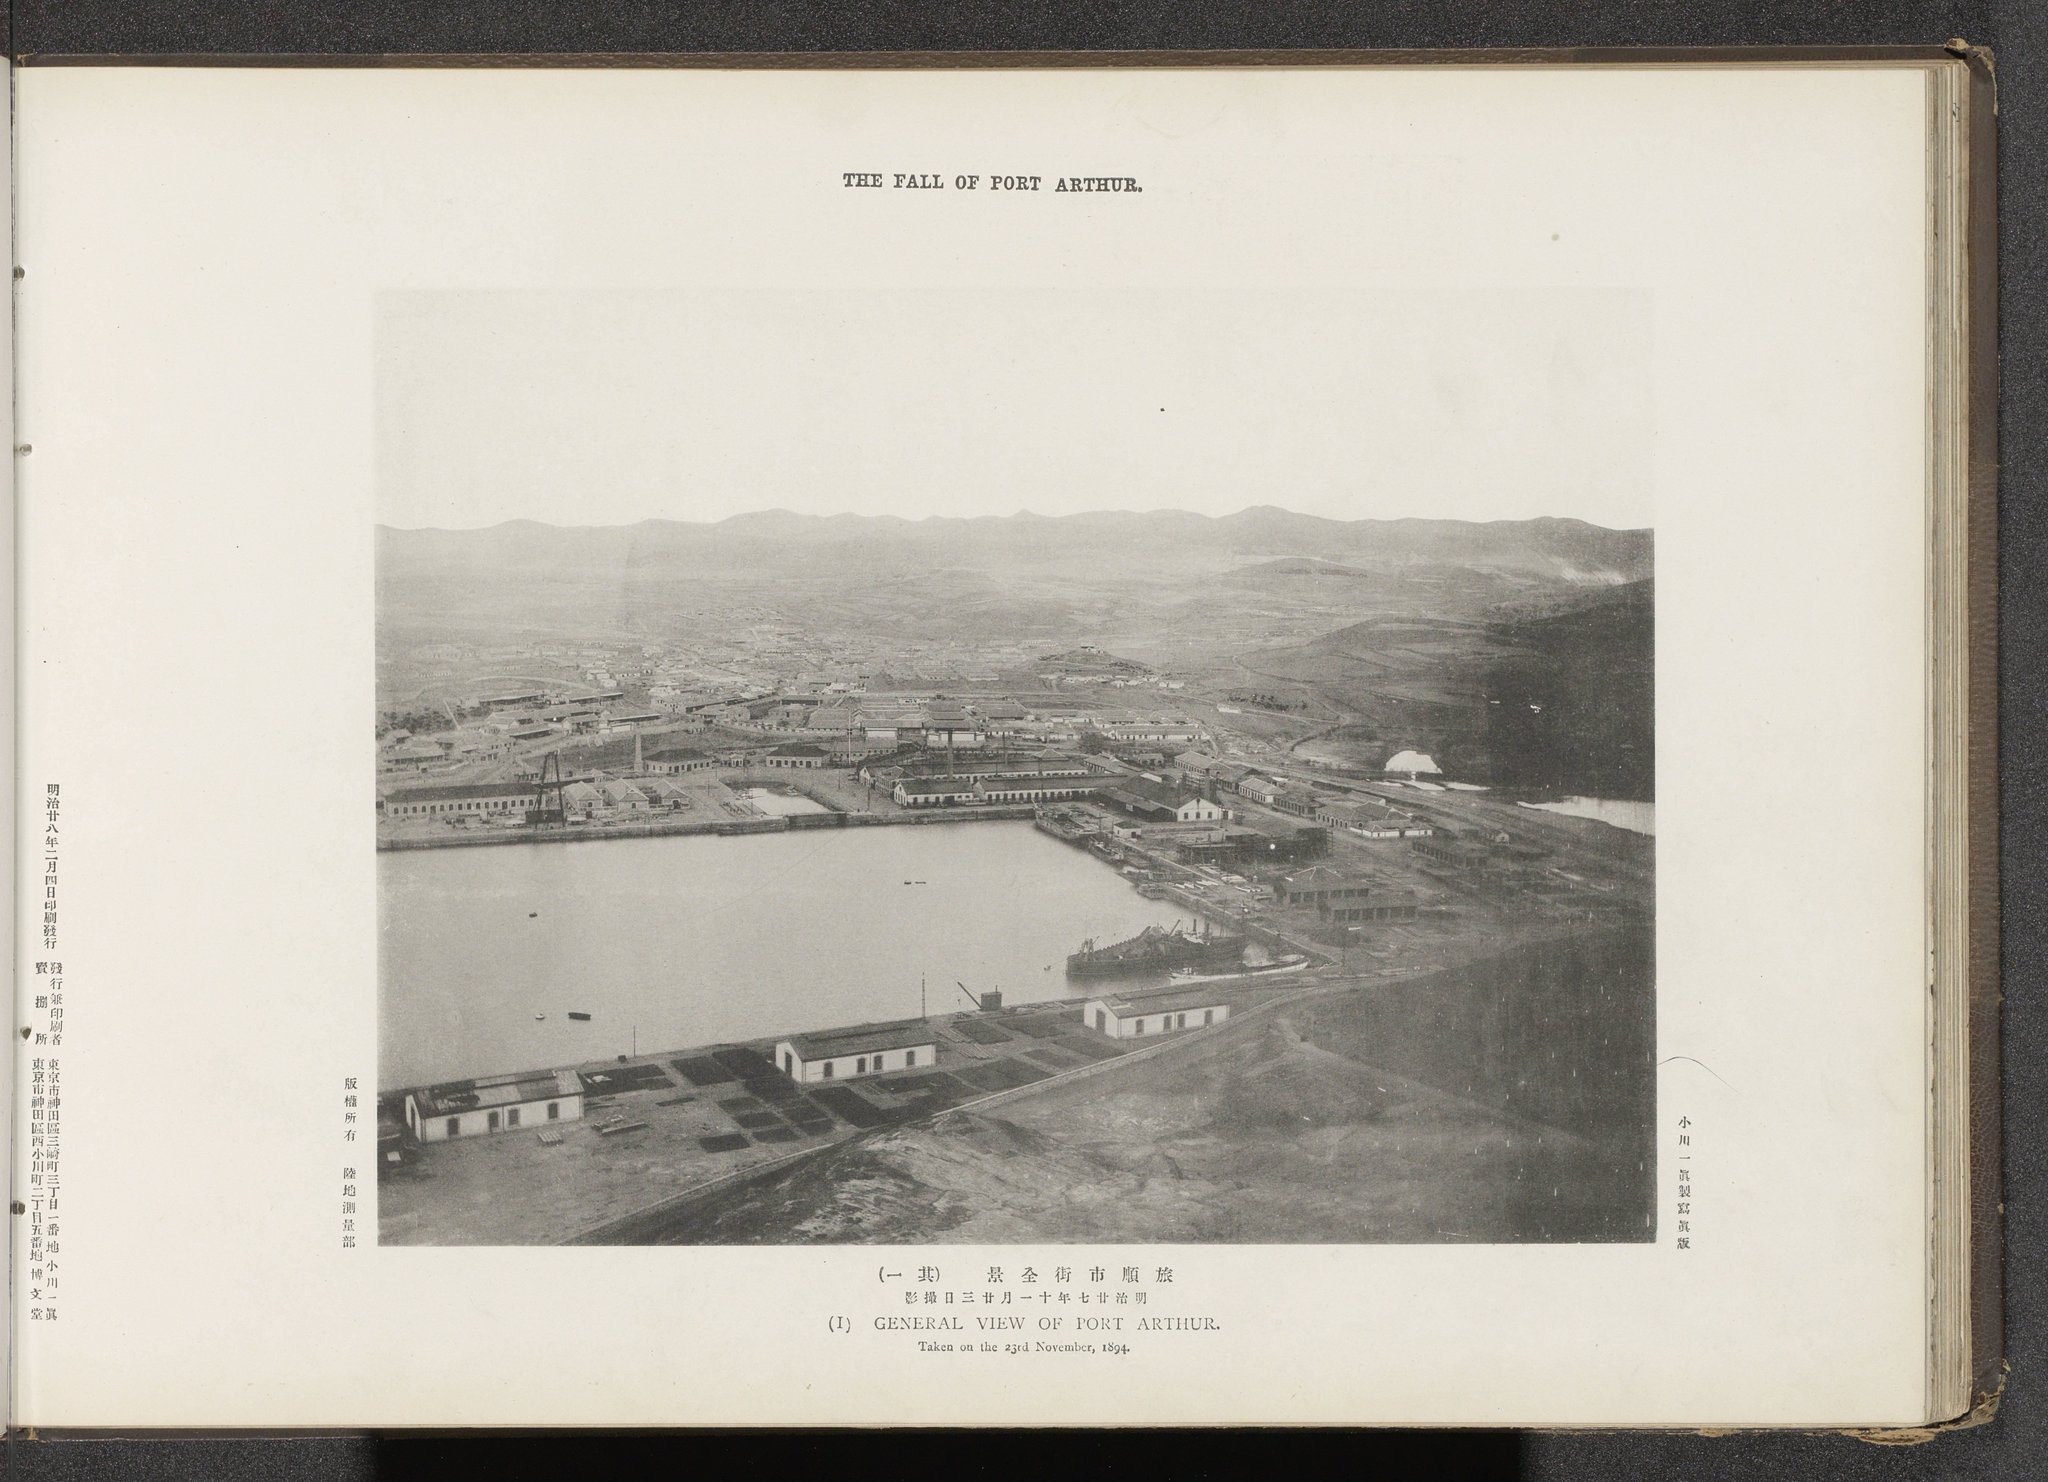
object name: photomechanical print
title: General view of Port Arthur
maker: kazumasa ogawa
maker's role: auteur, fotograaf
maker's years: 1860-1929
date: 1894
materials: paper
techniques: photograph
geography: japan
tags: city-view in general; 'veduta'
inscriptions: inscription: ‘The fall of Port Arthur.’